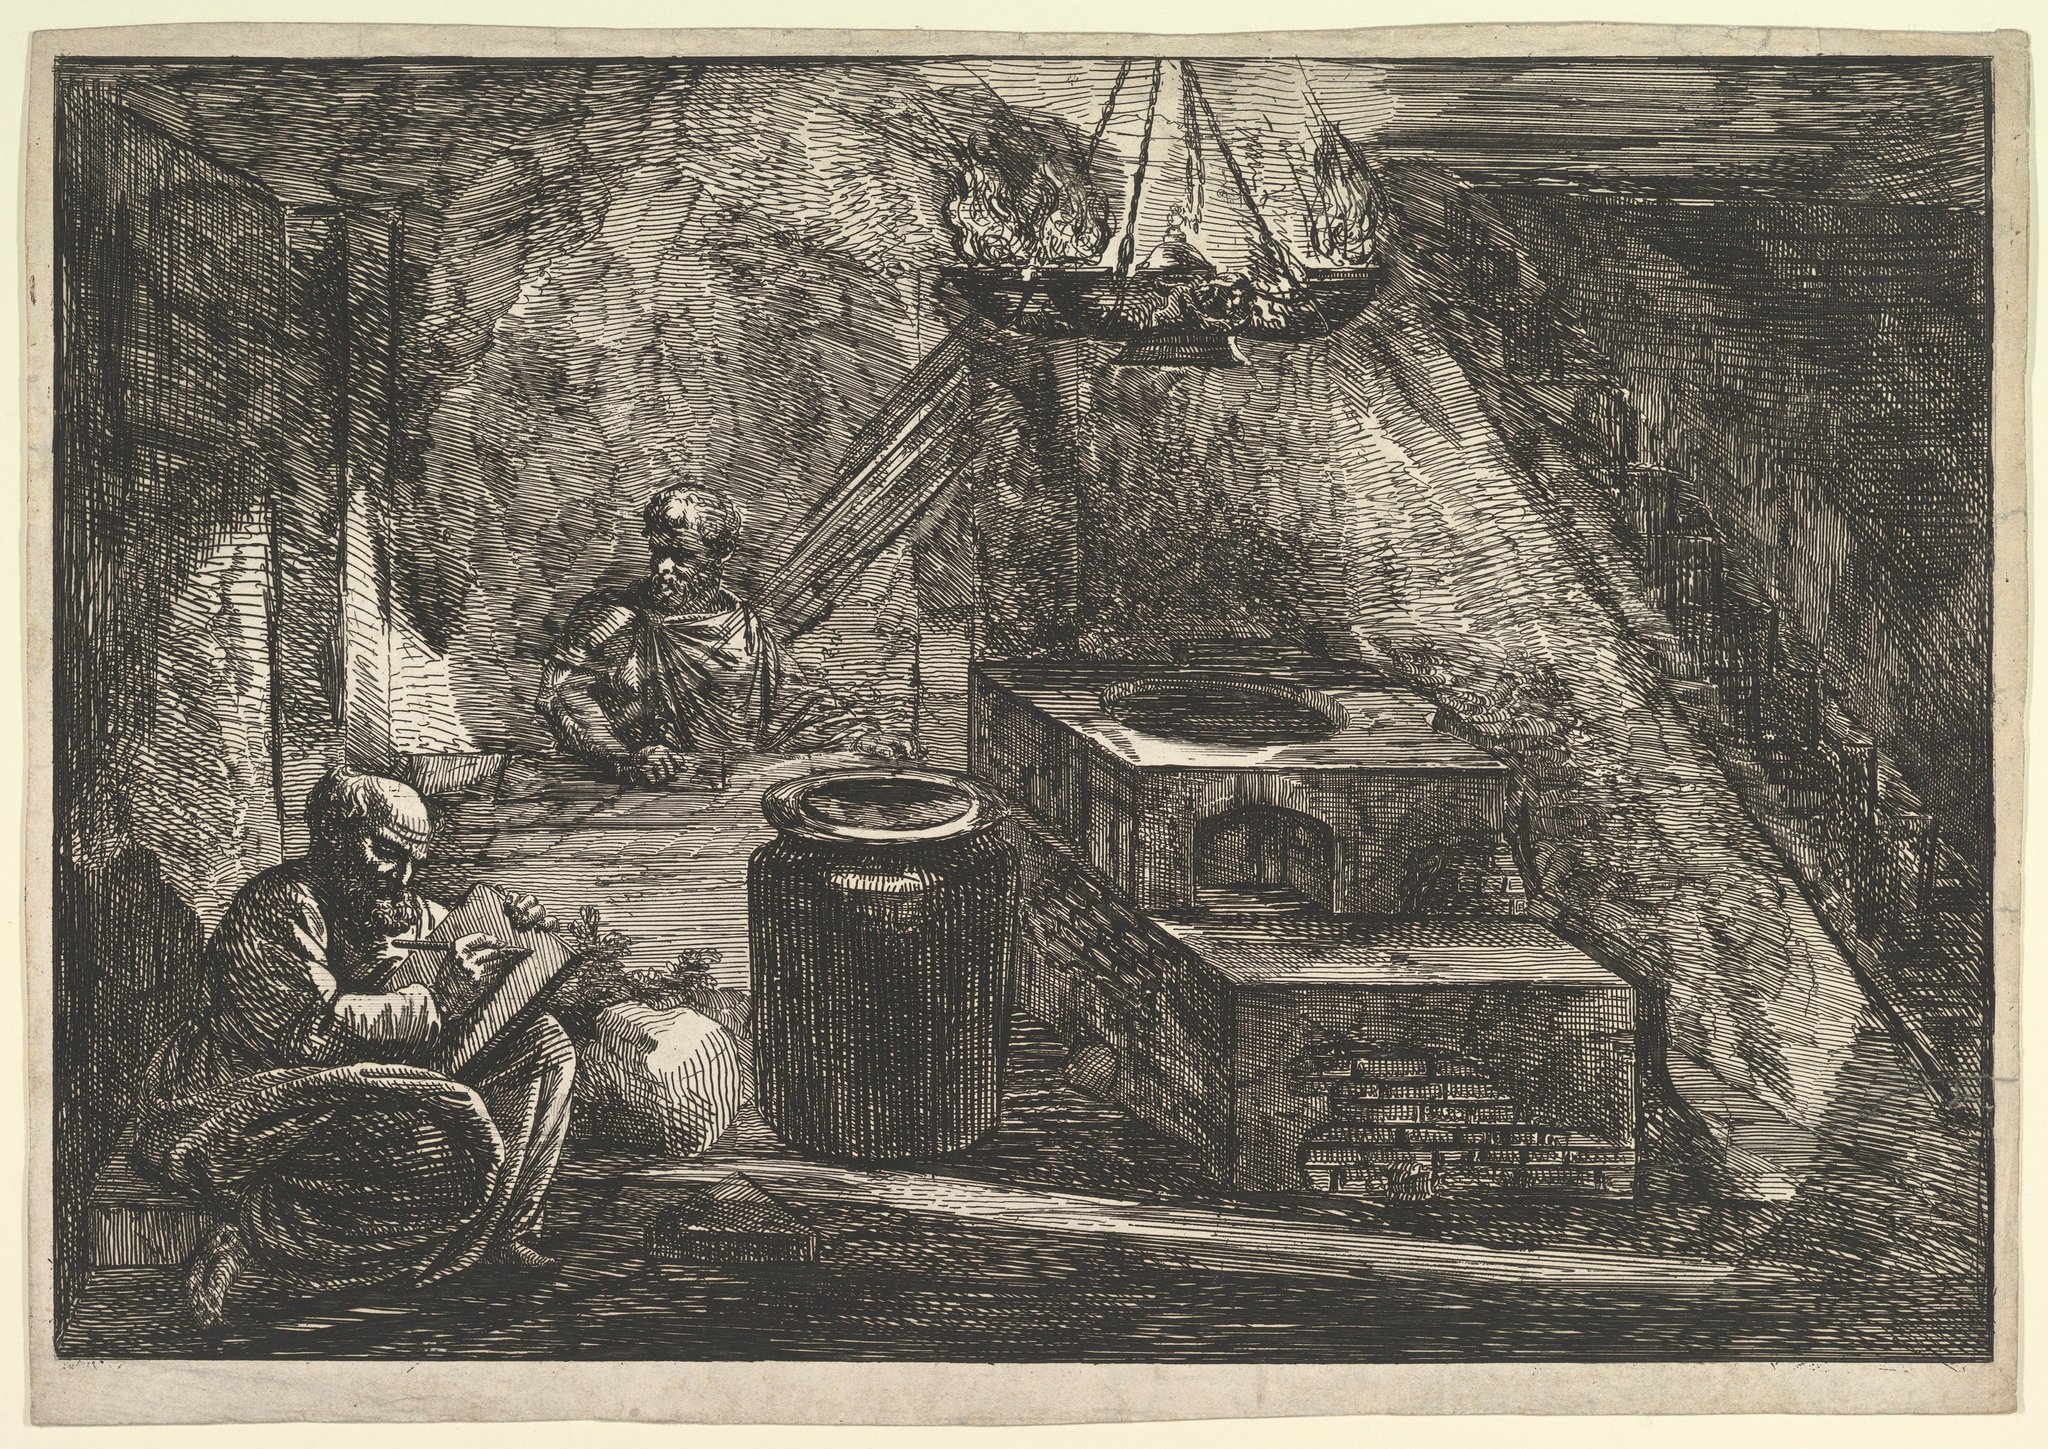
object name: print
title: Plate 45, Volume II of "Antiquités de la Grande-Grèce"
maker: francesco piranesi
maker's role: artist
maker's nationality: italian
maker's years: 1758-1810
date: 1807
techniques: etching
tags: men,writing